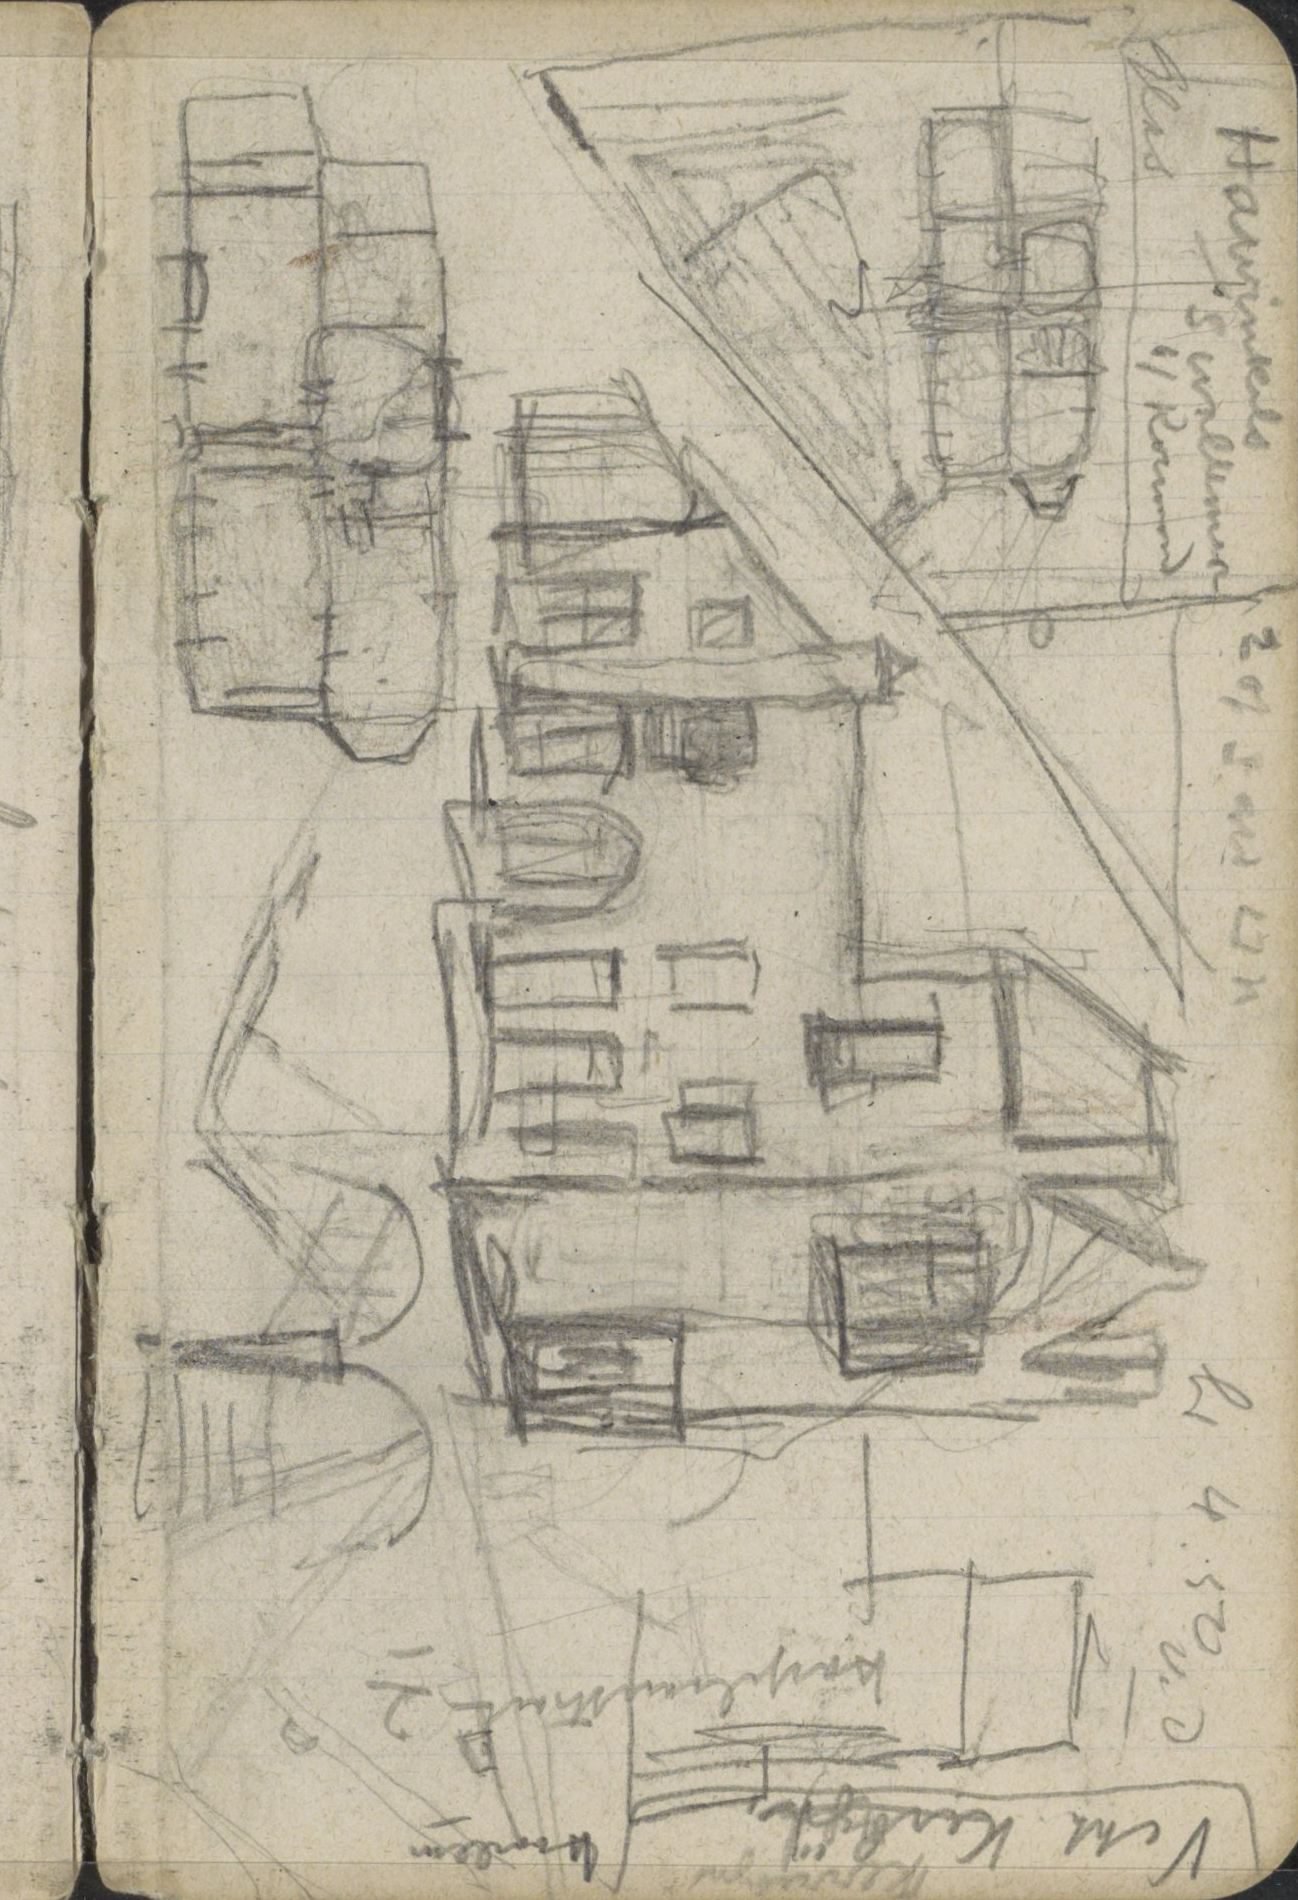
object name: sketchbook leaf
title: Studieblad met architectuurstudies en voorwerpen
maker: george hendrik breitner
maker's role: draughtsman, painter, print maker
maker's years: 1857-1923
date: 1903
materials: pencil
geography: amsterdam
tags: city-view, and landscape with man-made constructions, civic architecture; edifices; dwellings, heating stove, amsterdam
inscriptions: annotation: ‘[...]’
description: Pagina 82 uit een schetsboek met 32 bladen.